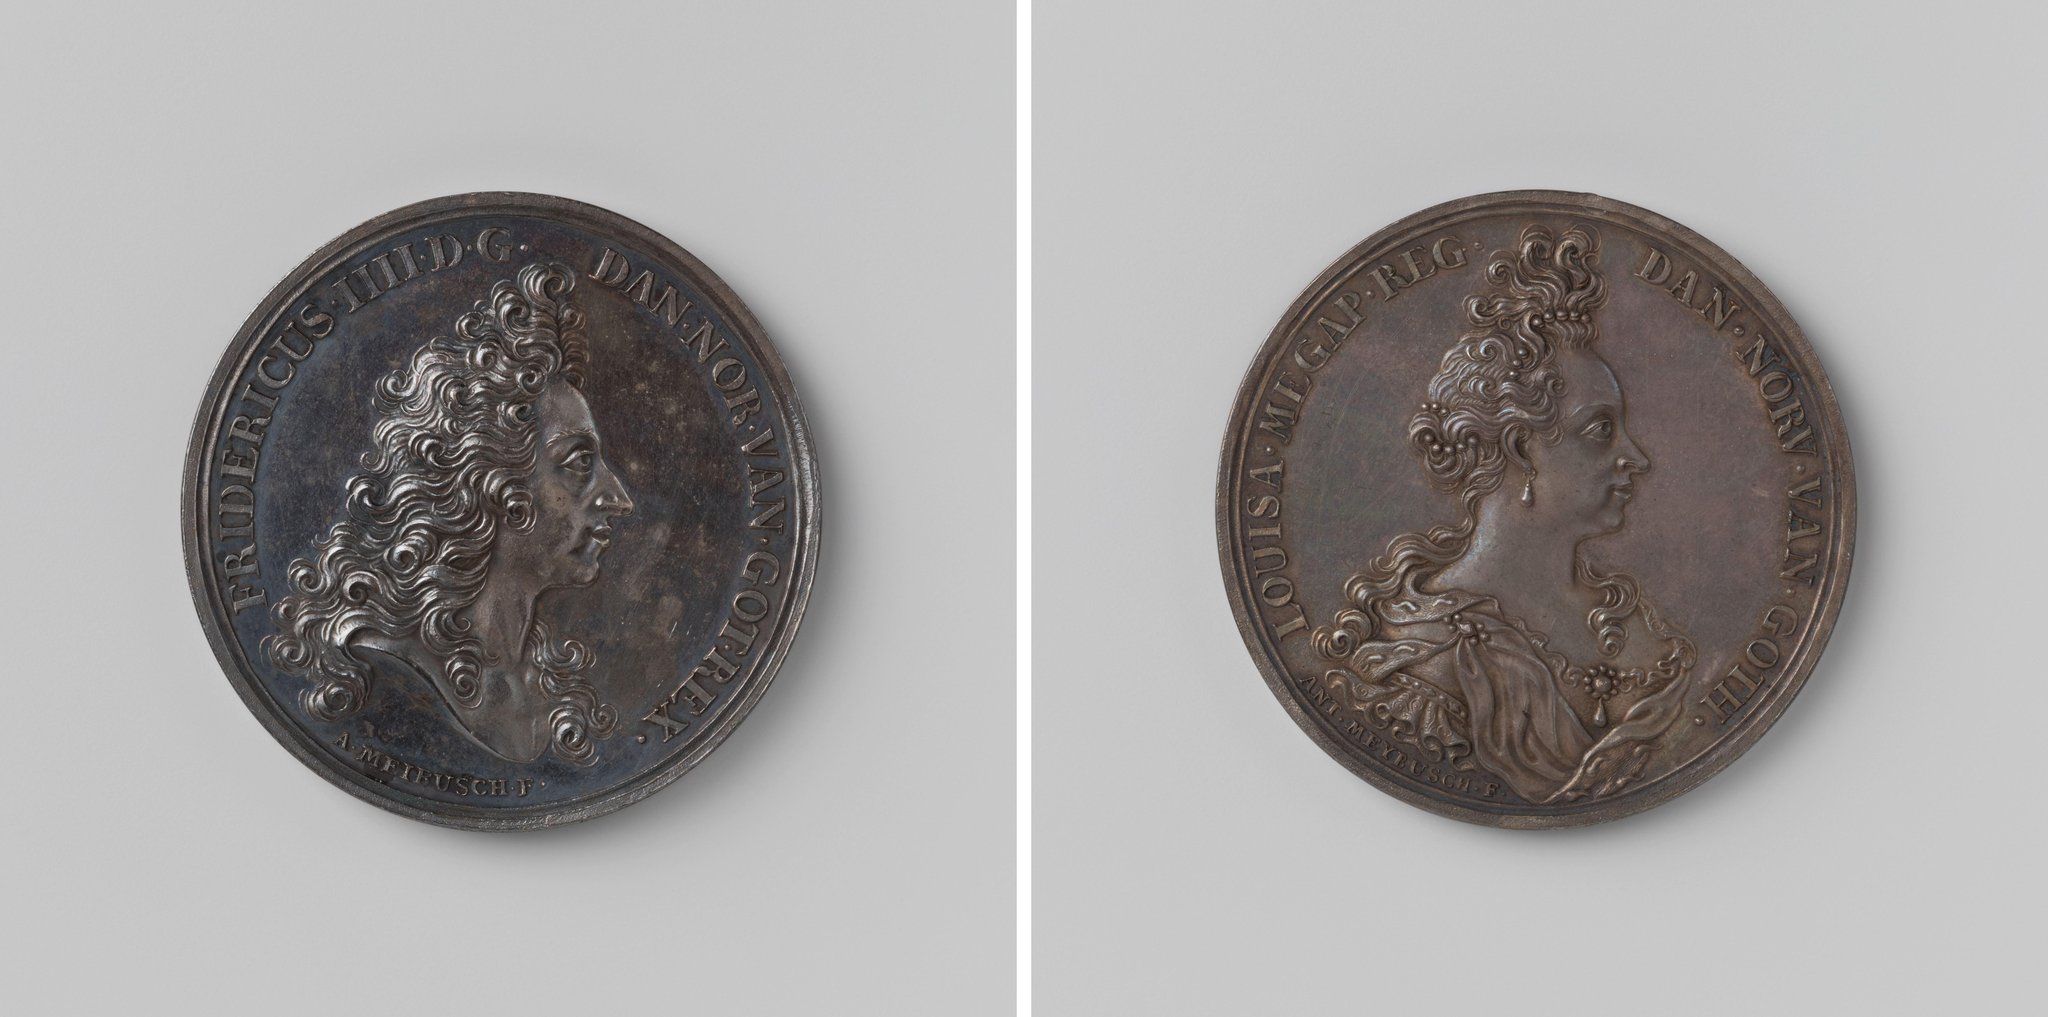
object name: history medal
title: Frederik IV en Louisa, koning en koningin van Denemarken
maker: anton meybusch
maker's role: medailleur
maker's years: 1645-1702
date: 1699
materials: silver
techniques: striking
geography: copenhagen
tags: frederik iv (koning van denemarken en noorwegen)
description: Zilveren penning. Voorzijde: borststuk man binnen omschrift. Keerzijde: borststuk vrouw binnen omschrift